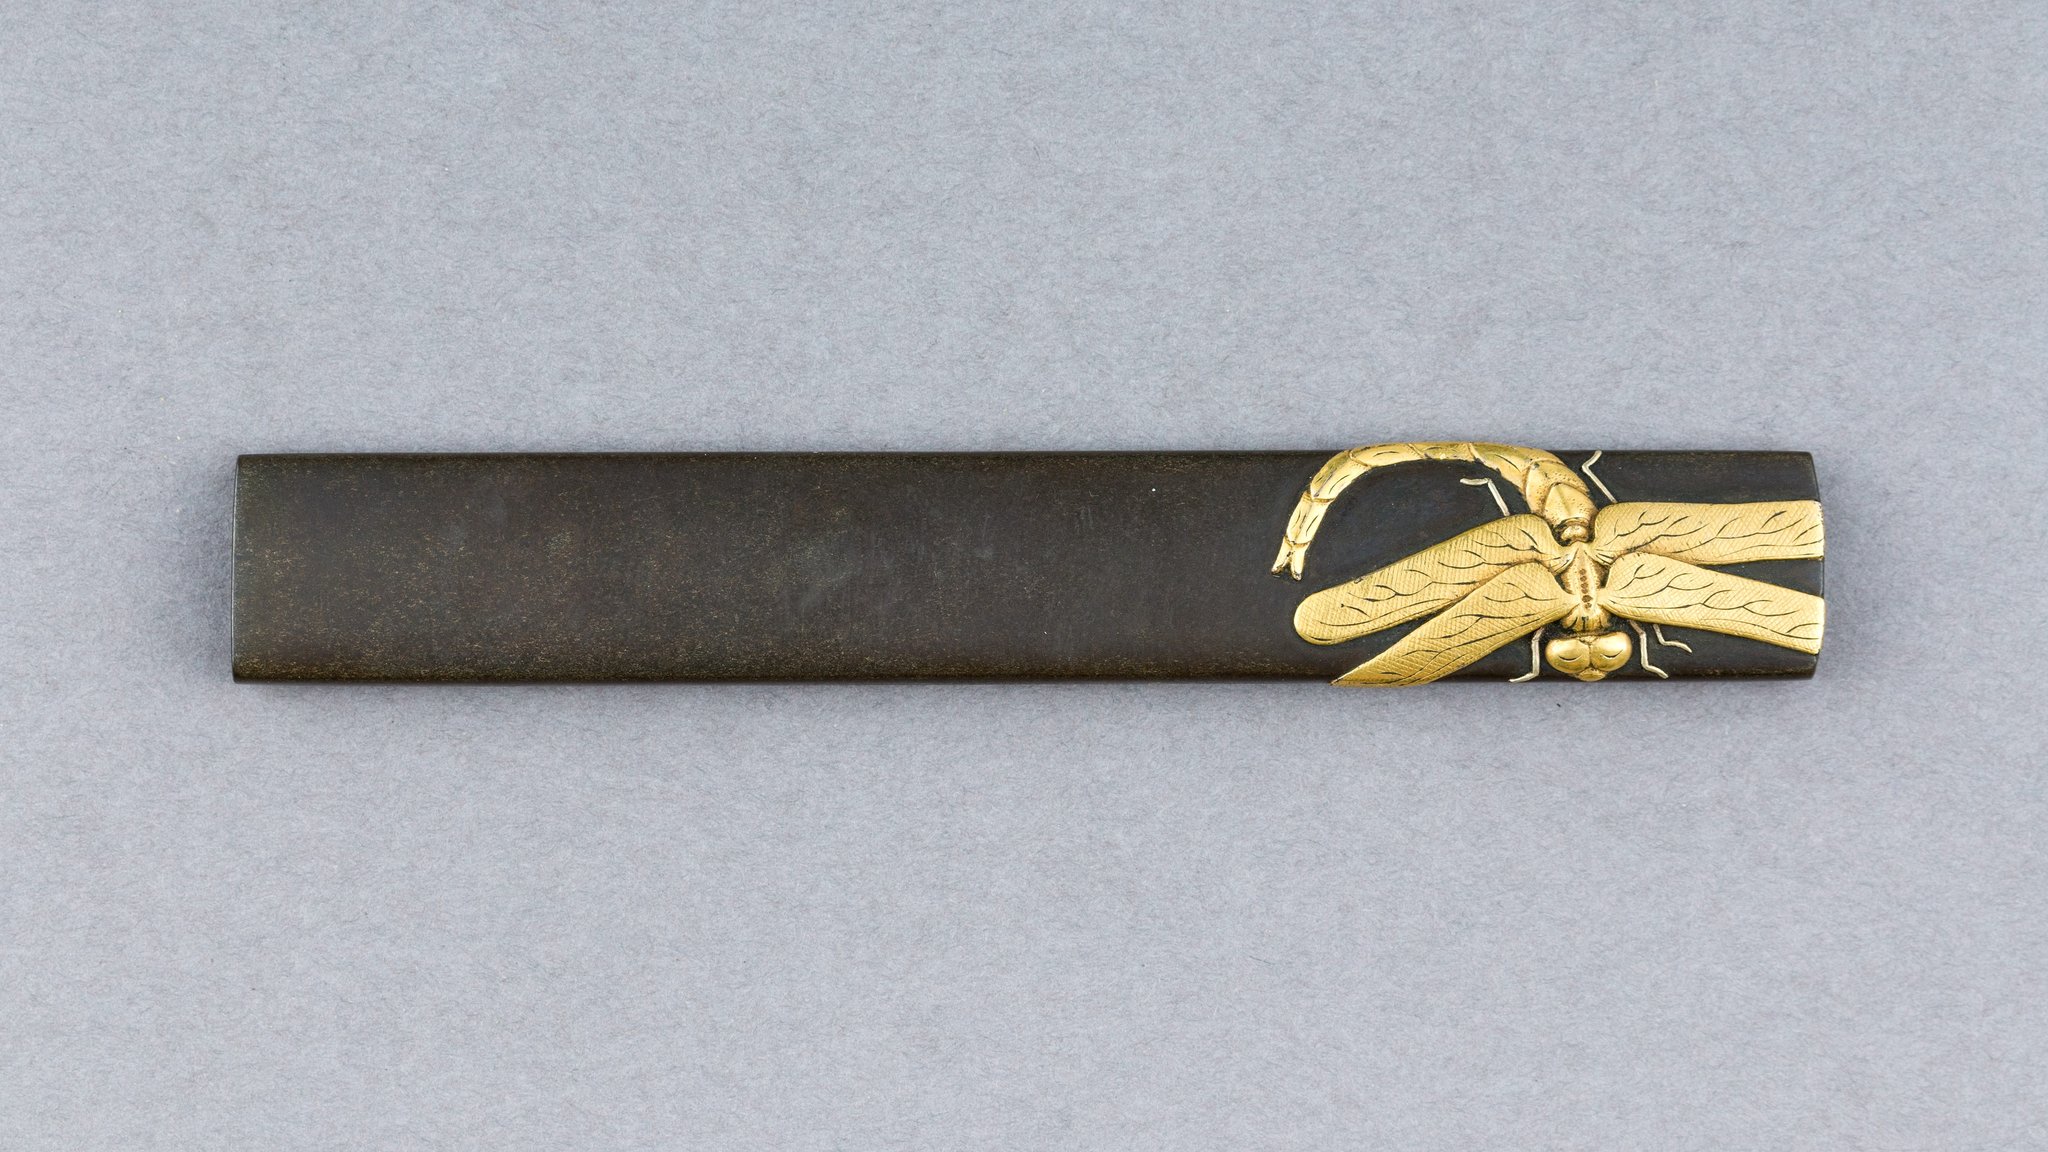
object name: knife handle kozuka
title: Knife Handle (Kozuka)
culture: japanese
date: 1615-1868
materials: silver alloy, gold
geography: japan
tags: dragonflies